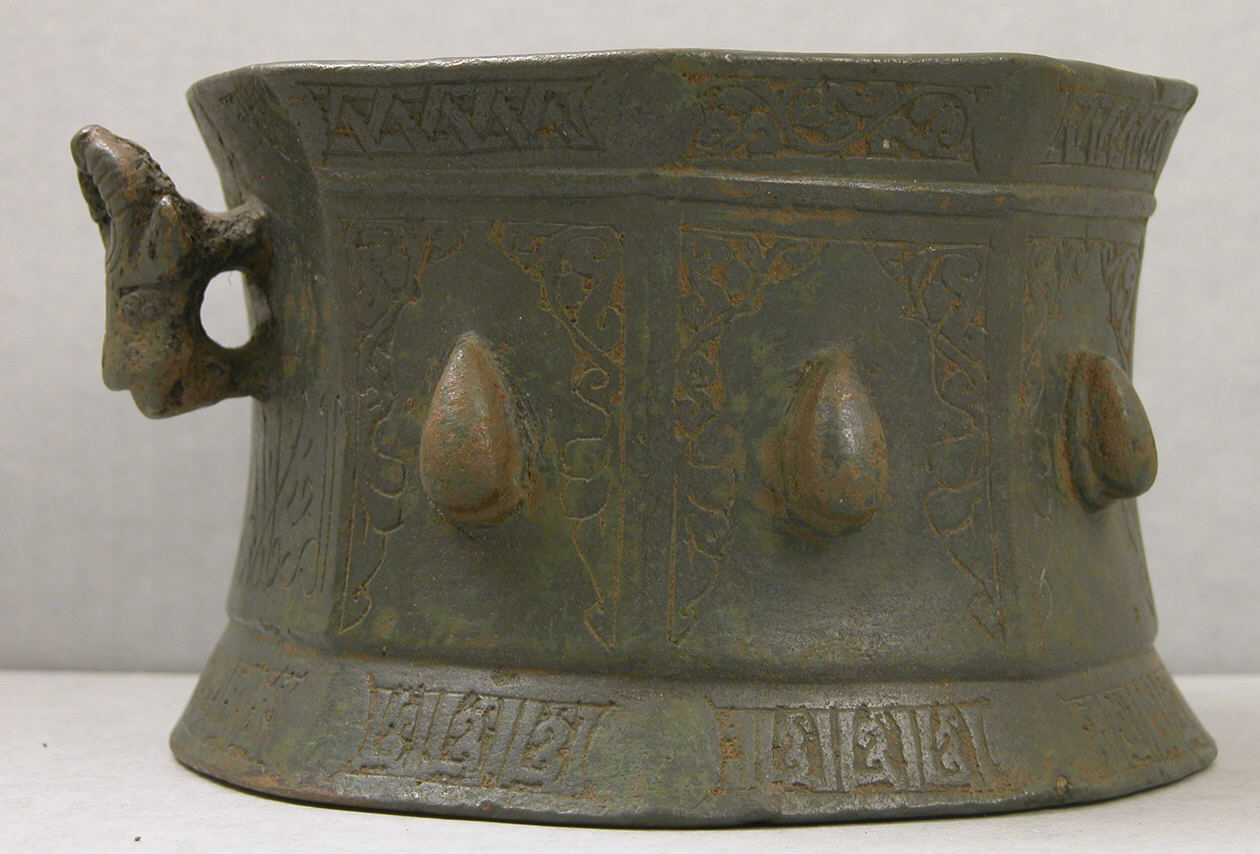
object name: mortar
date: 1001-1200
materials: bronze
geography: iran